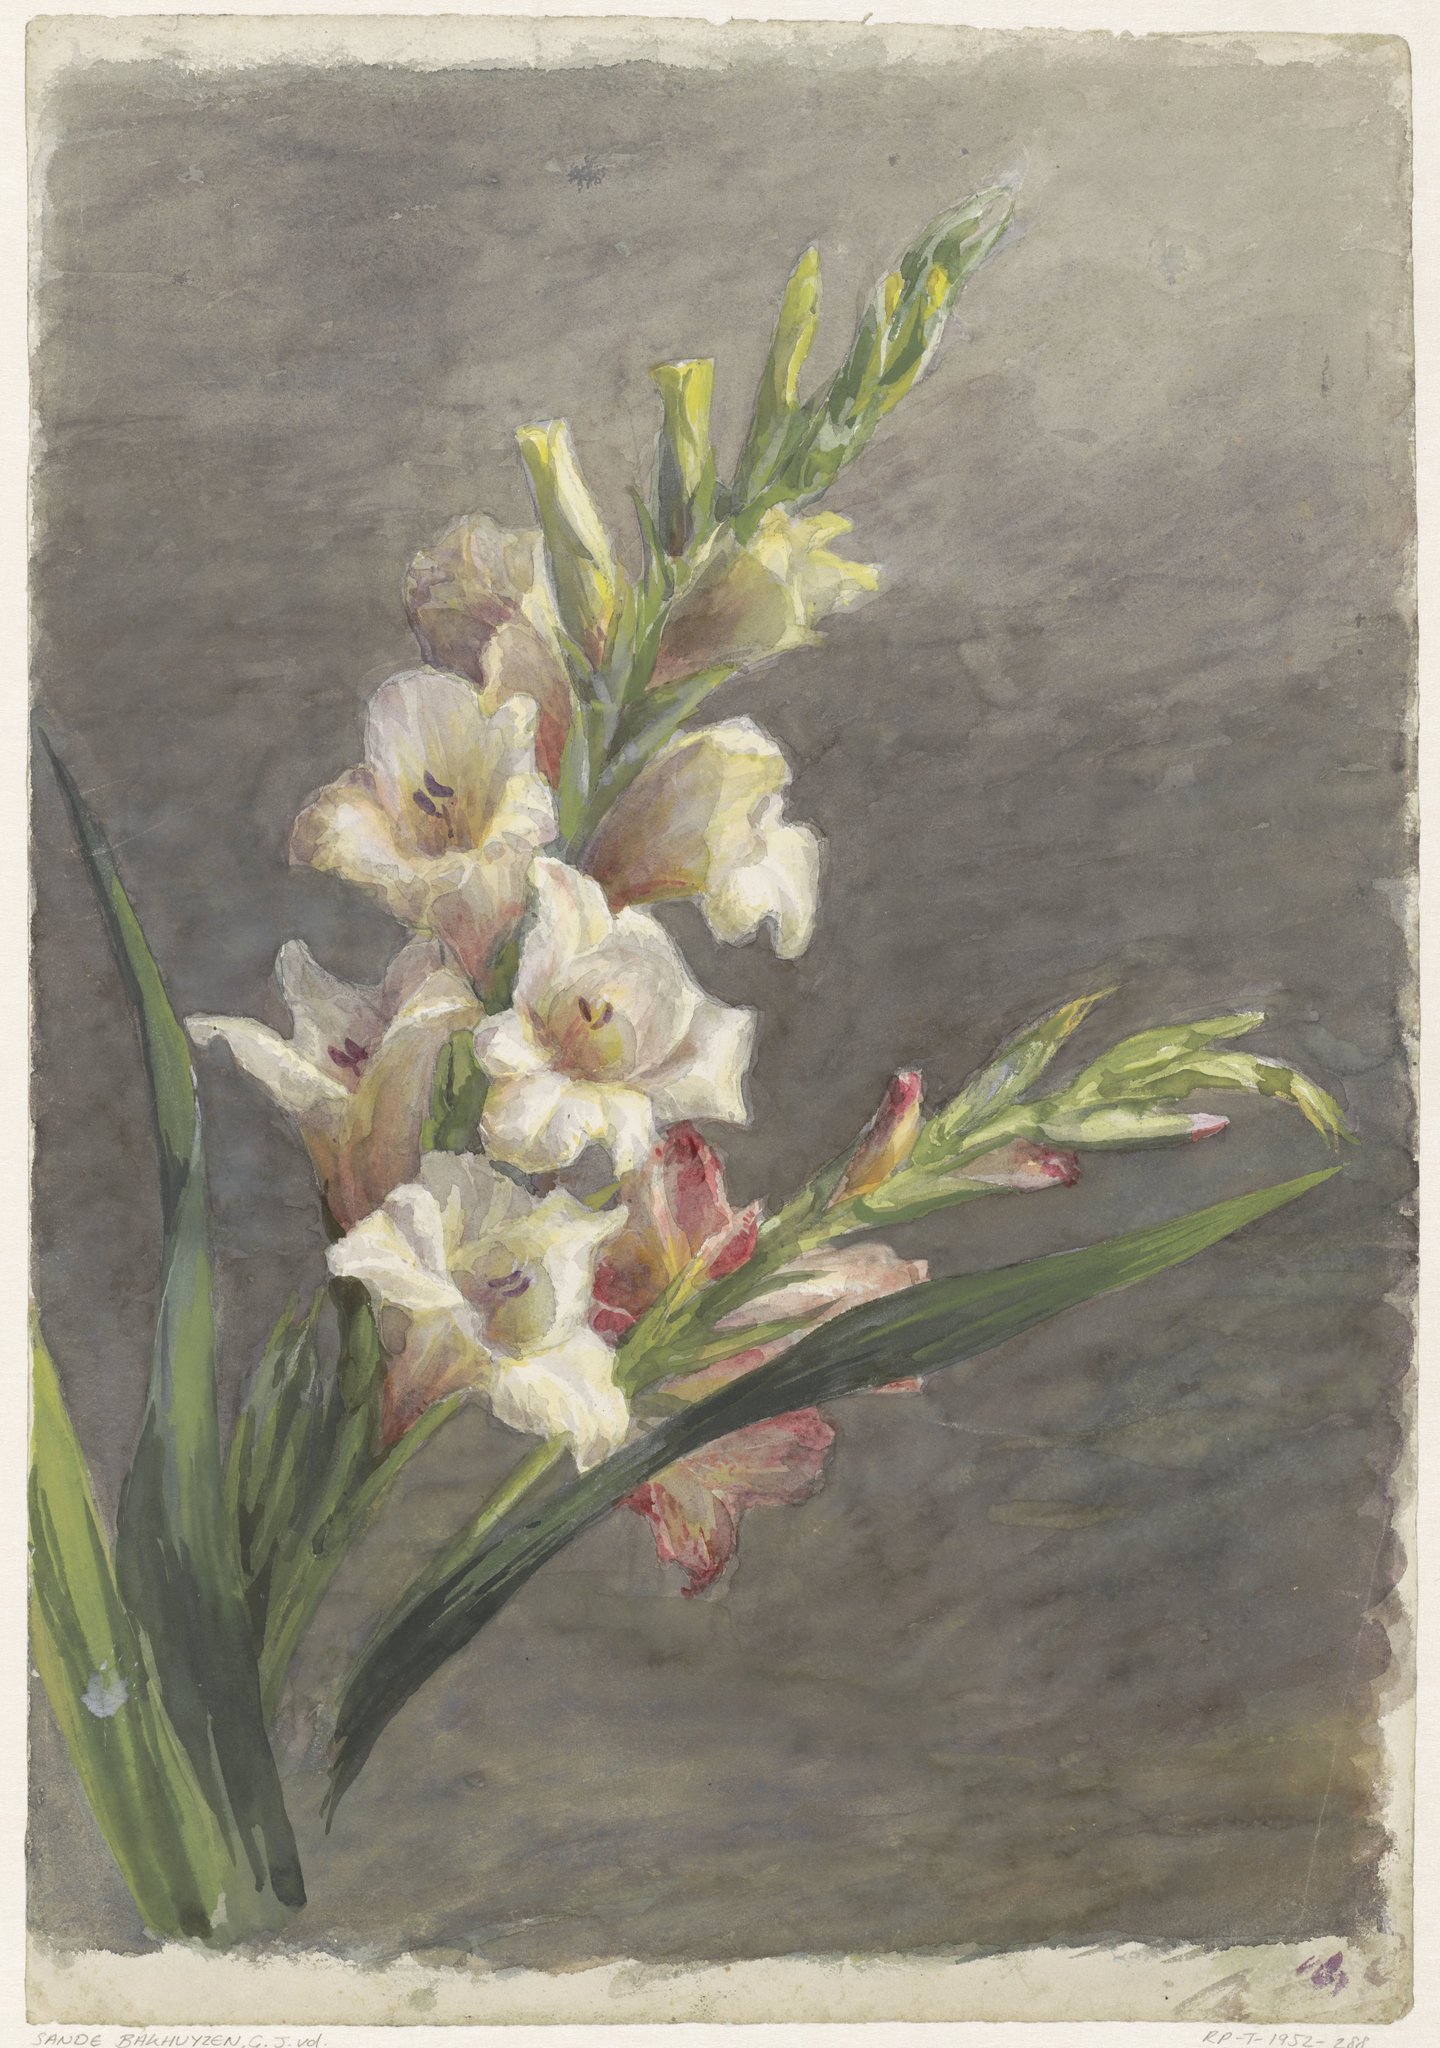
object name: drawing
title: Gladiolen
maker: gerardine jacoba van de sande bakhuyzen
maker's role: draughtsman, painter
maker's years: 1826-1895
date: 1836-1895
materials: paper, watercolor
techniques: brush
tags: flowers: gladiolus